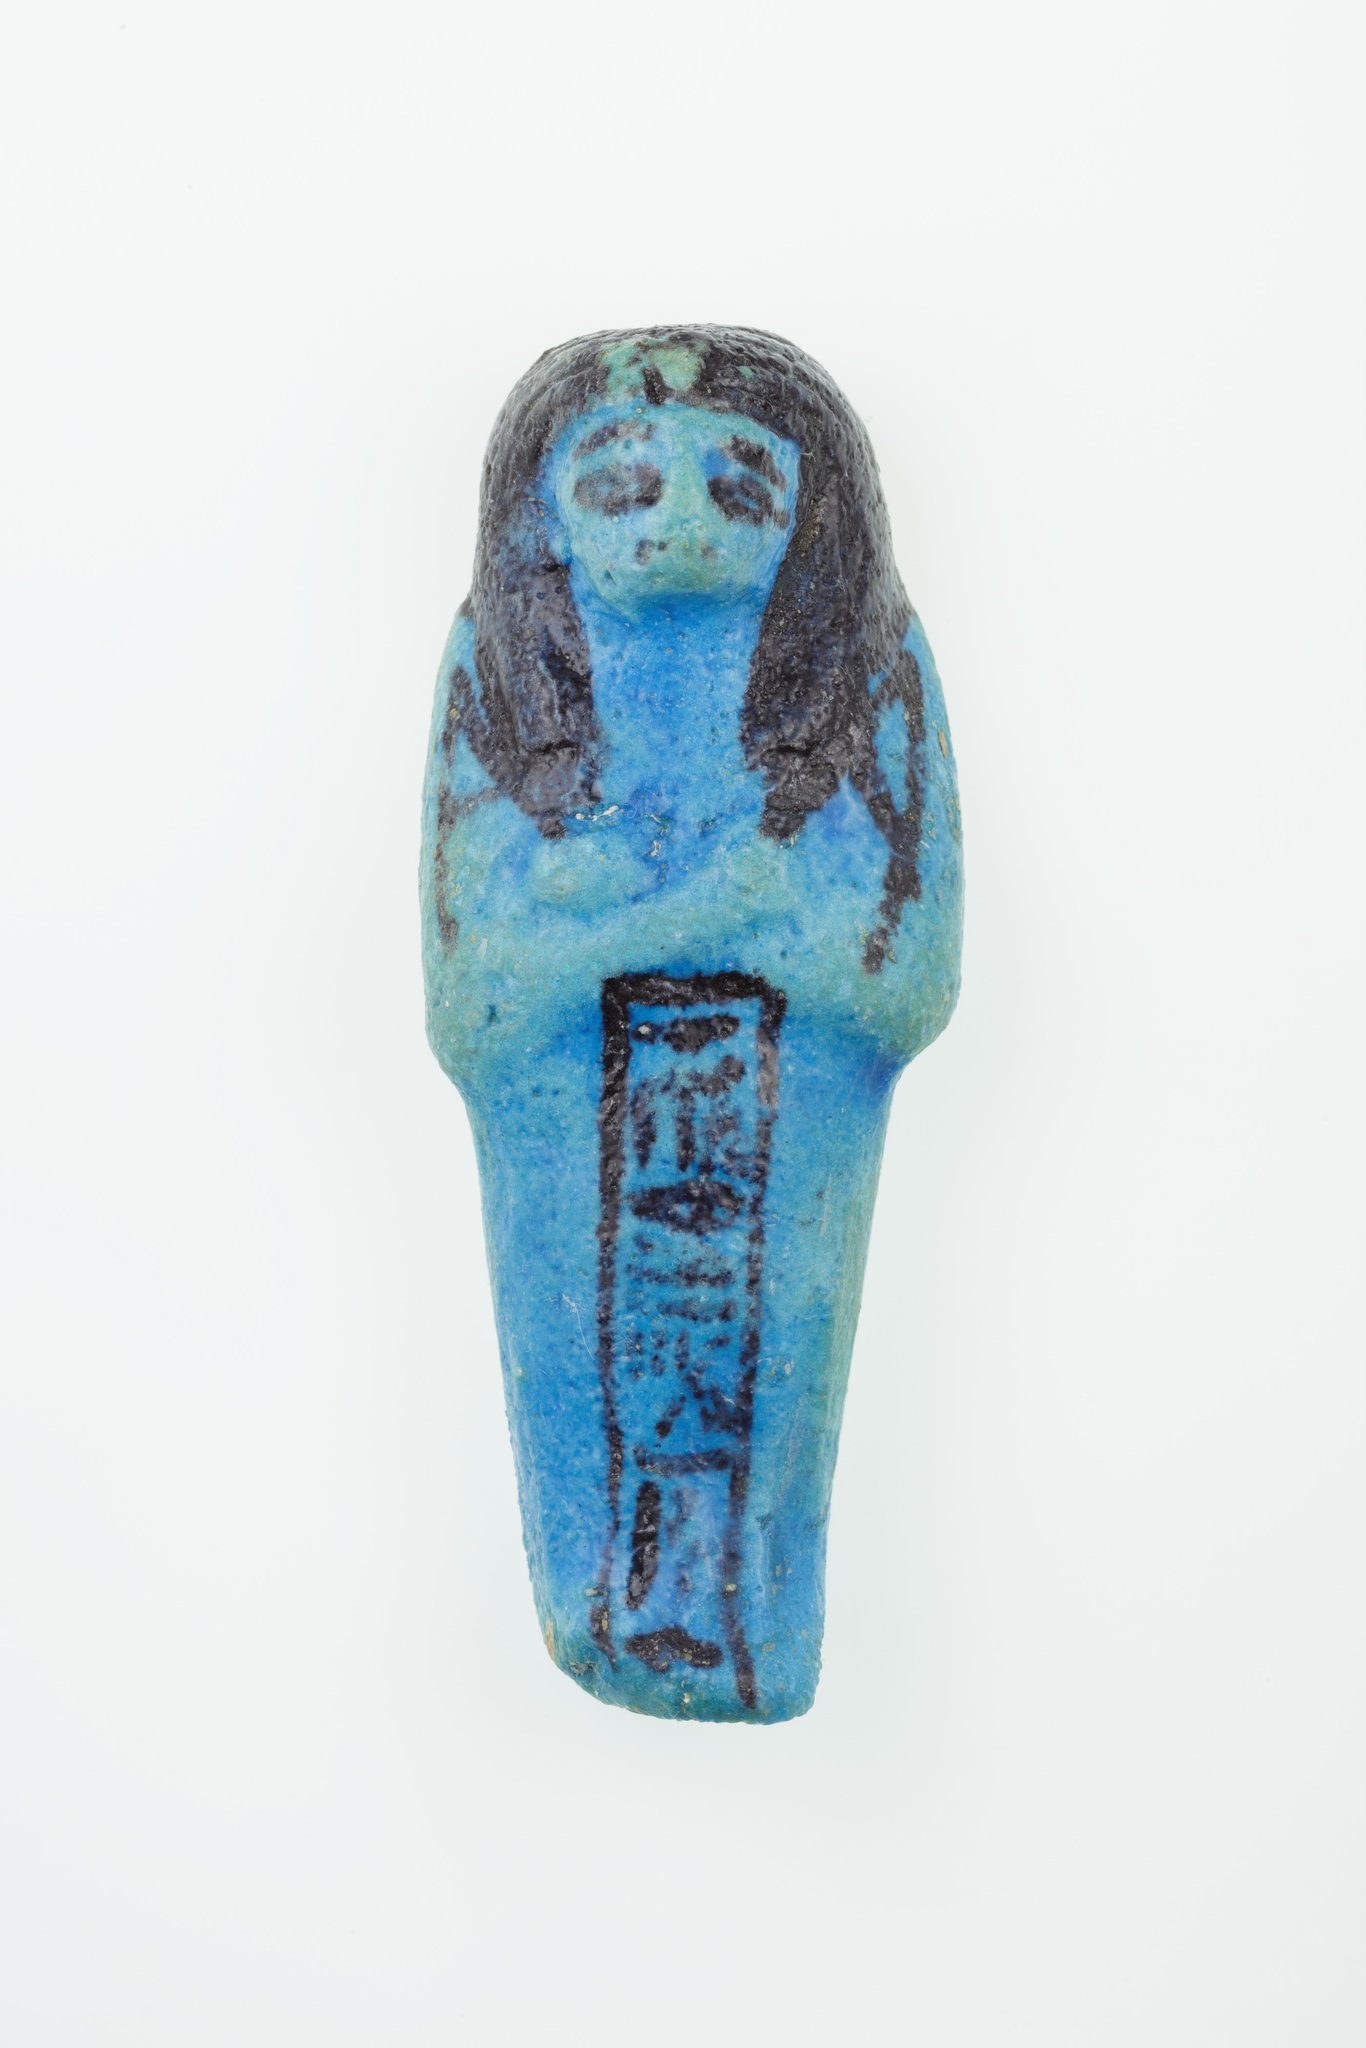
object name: shabti, worker, nauny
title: Worker Shabti of Nauny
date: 1050 BCE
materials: faience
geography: egypt